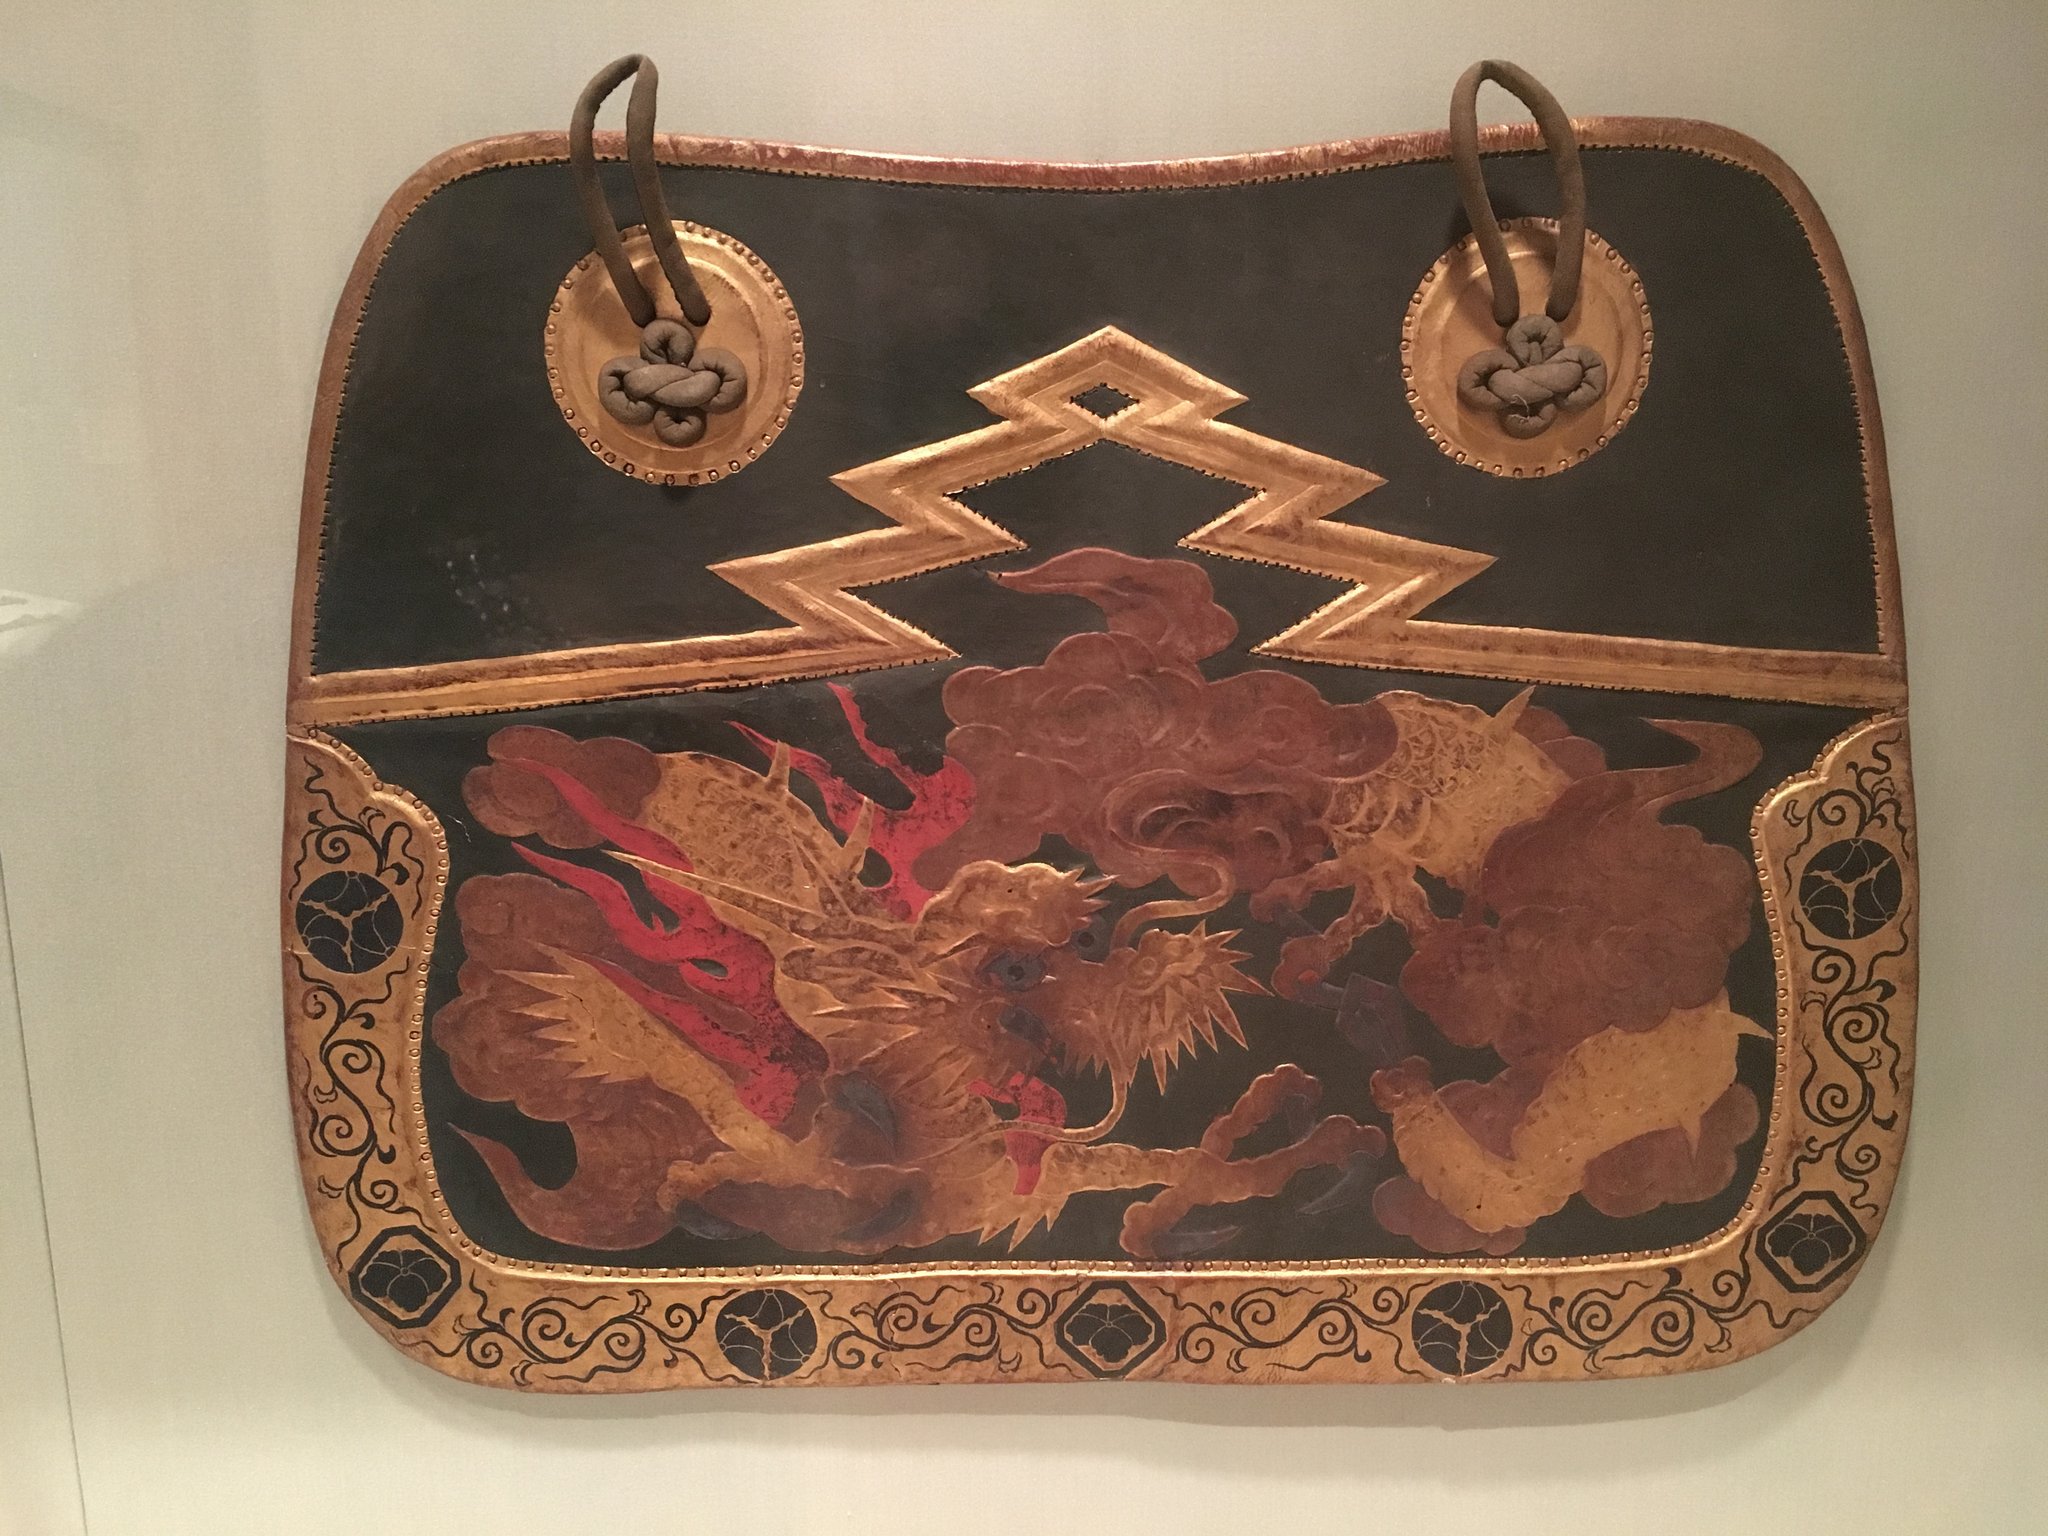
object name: saddle flap i aori i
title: Saddle Flaps (Aori)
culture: japanese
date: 1701-1800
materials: gold, leather, pigment, silk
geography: japan